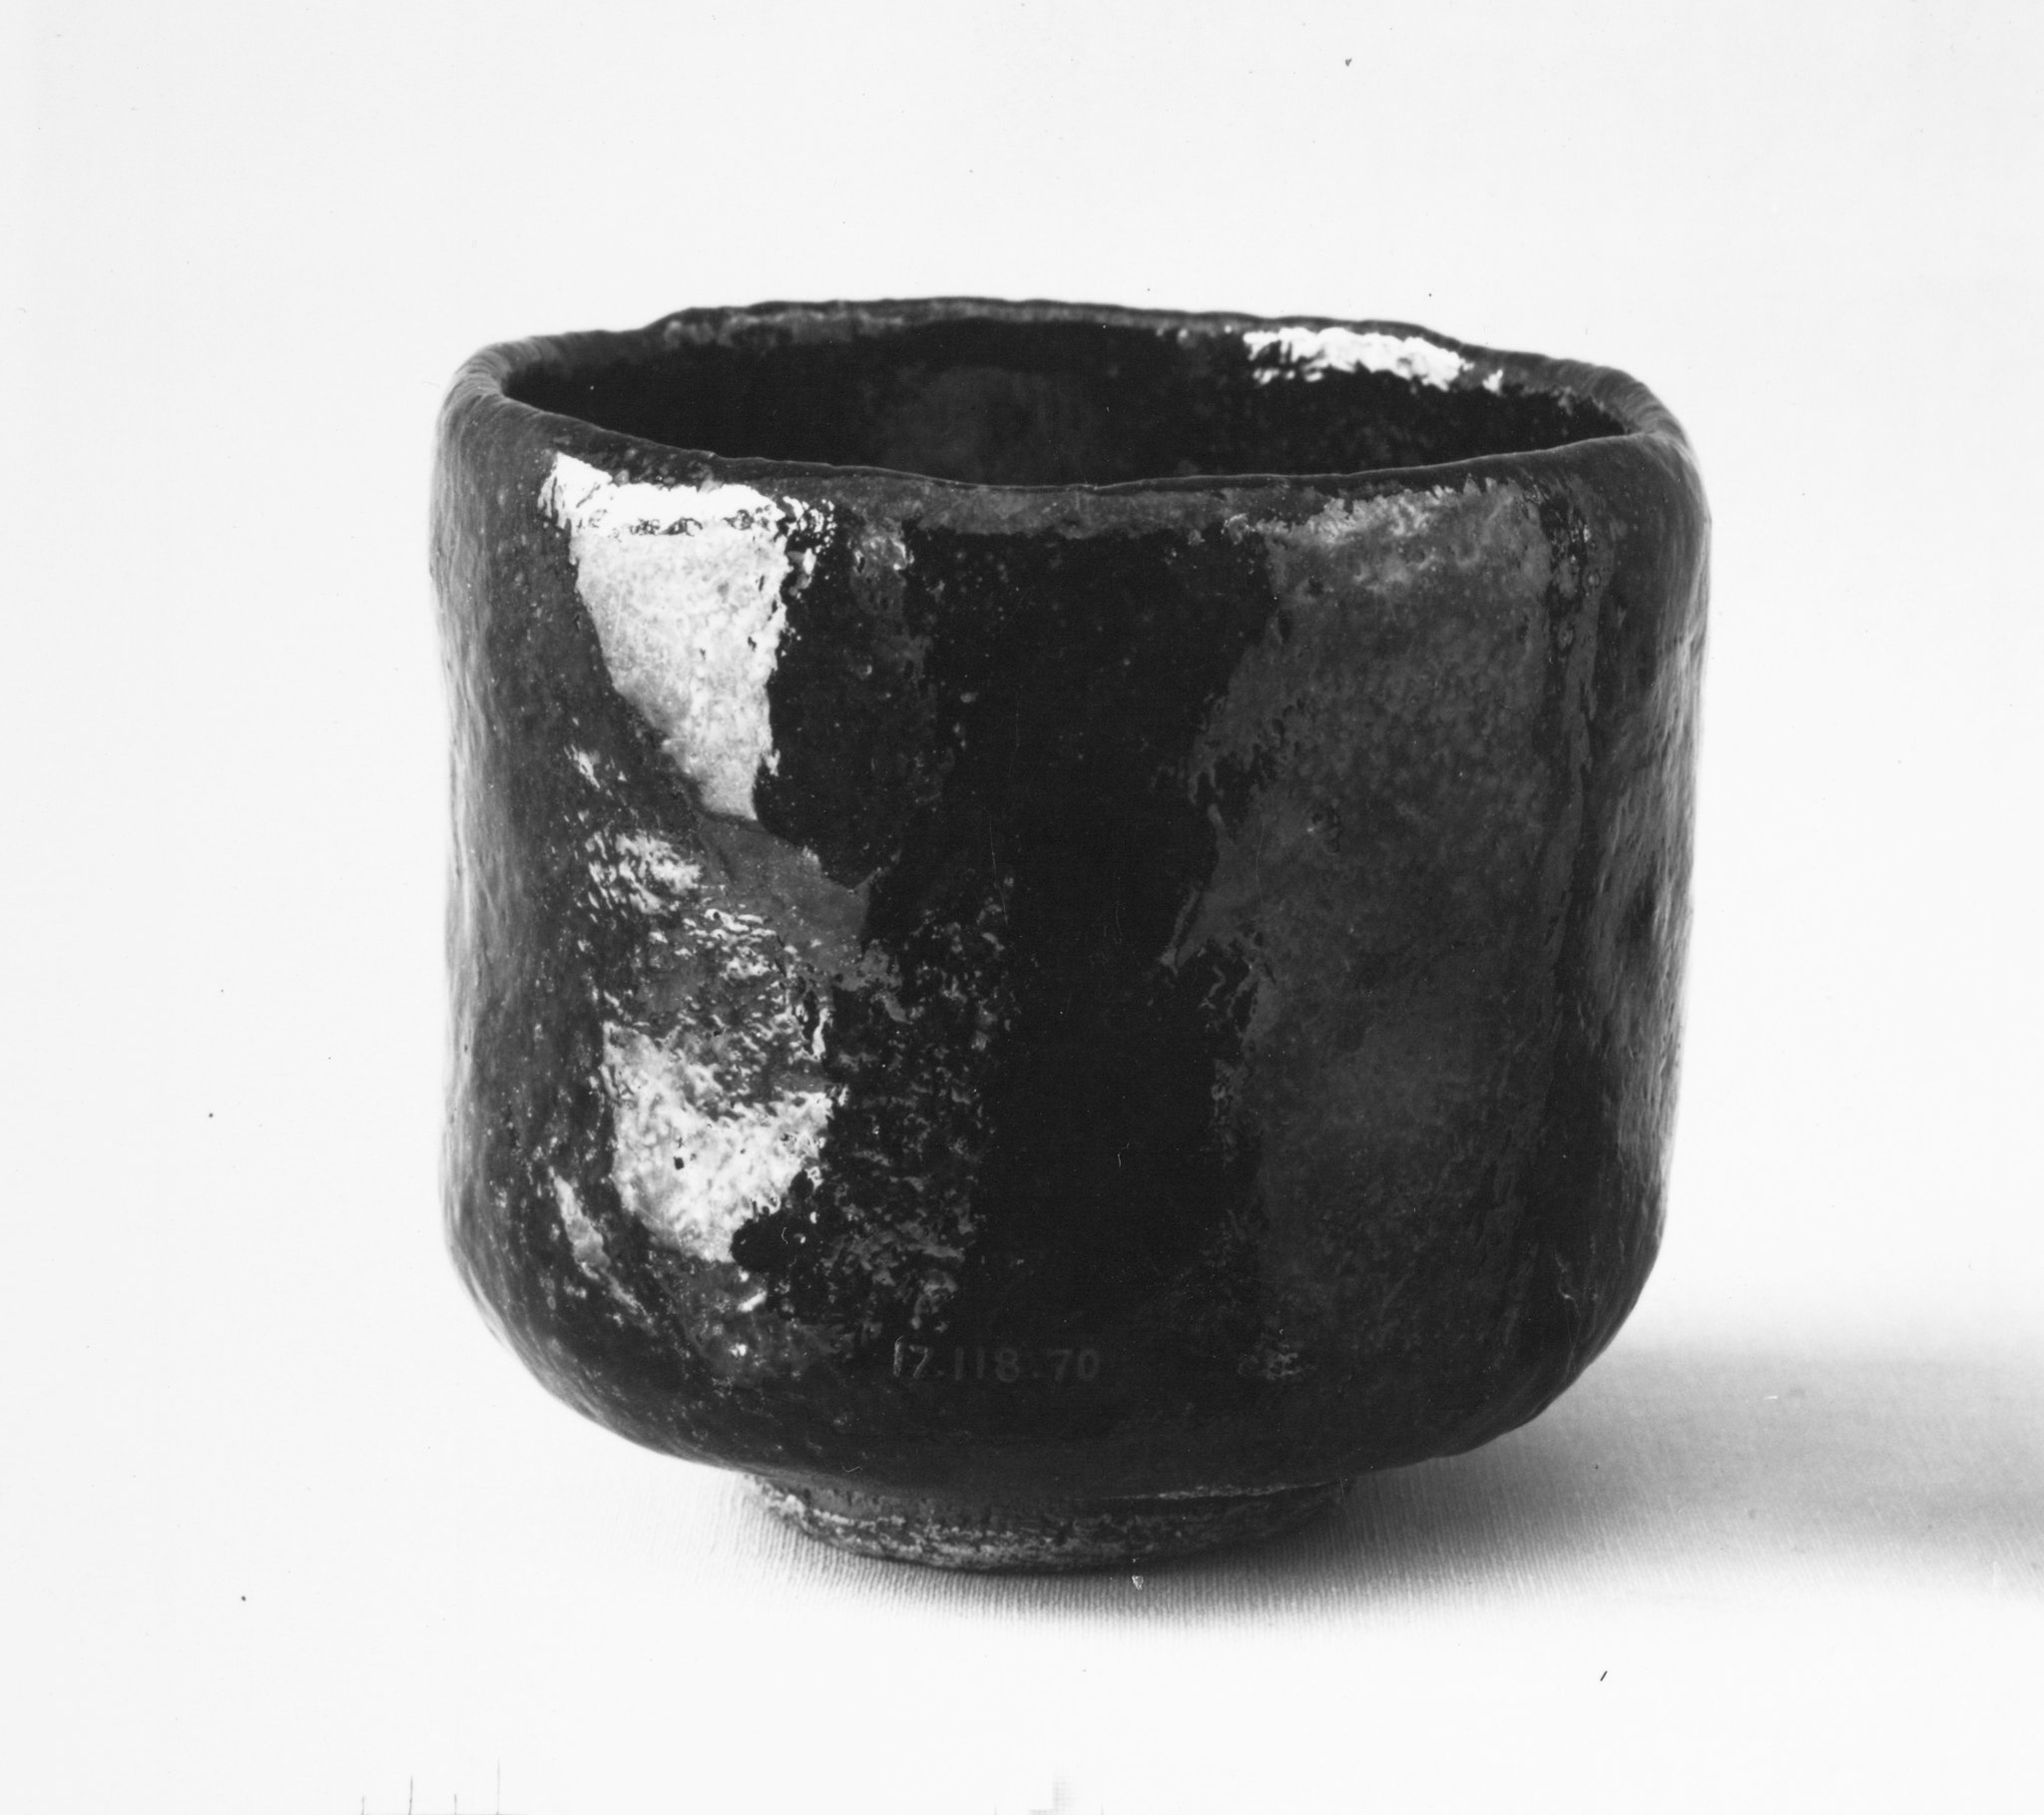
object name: teabowl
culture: japanese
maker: ryōnyu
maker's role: artist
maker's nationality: japanese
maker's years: 1735-1835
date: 1800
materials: clay, glaze